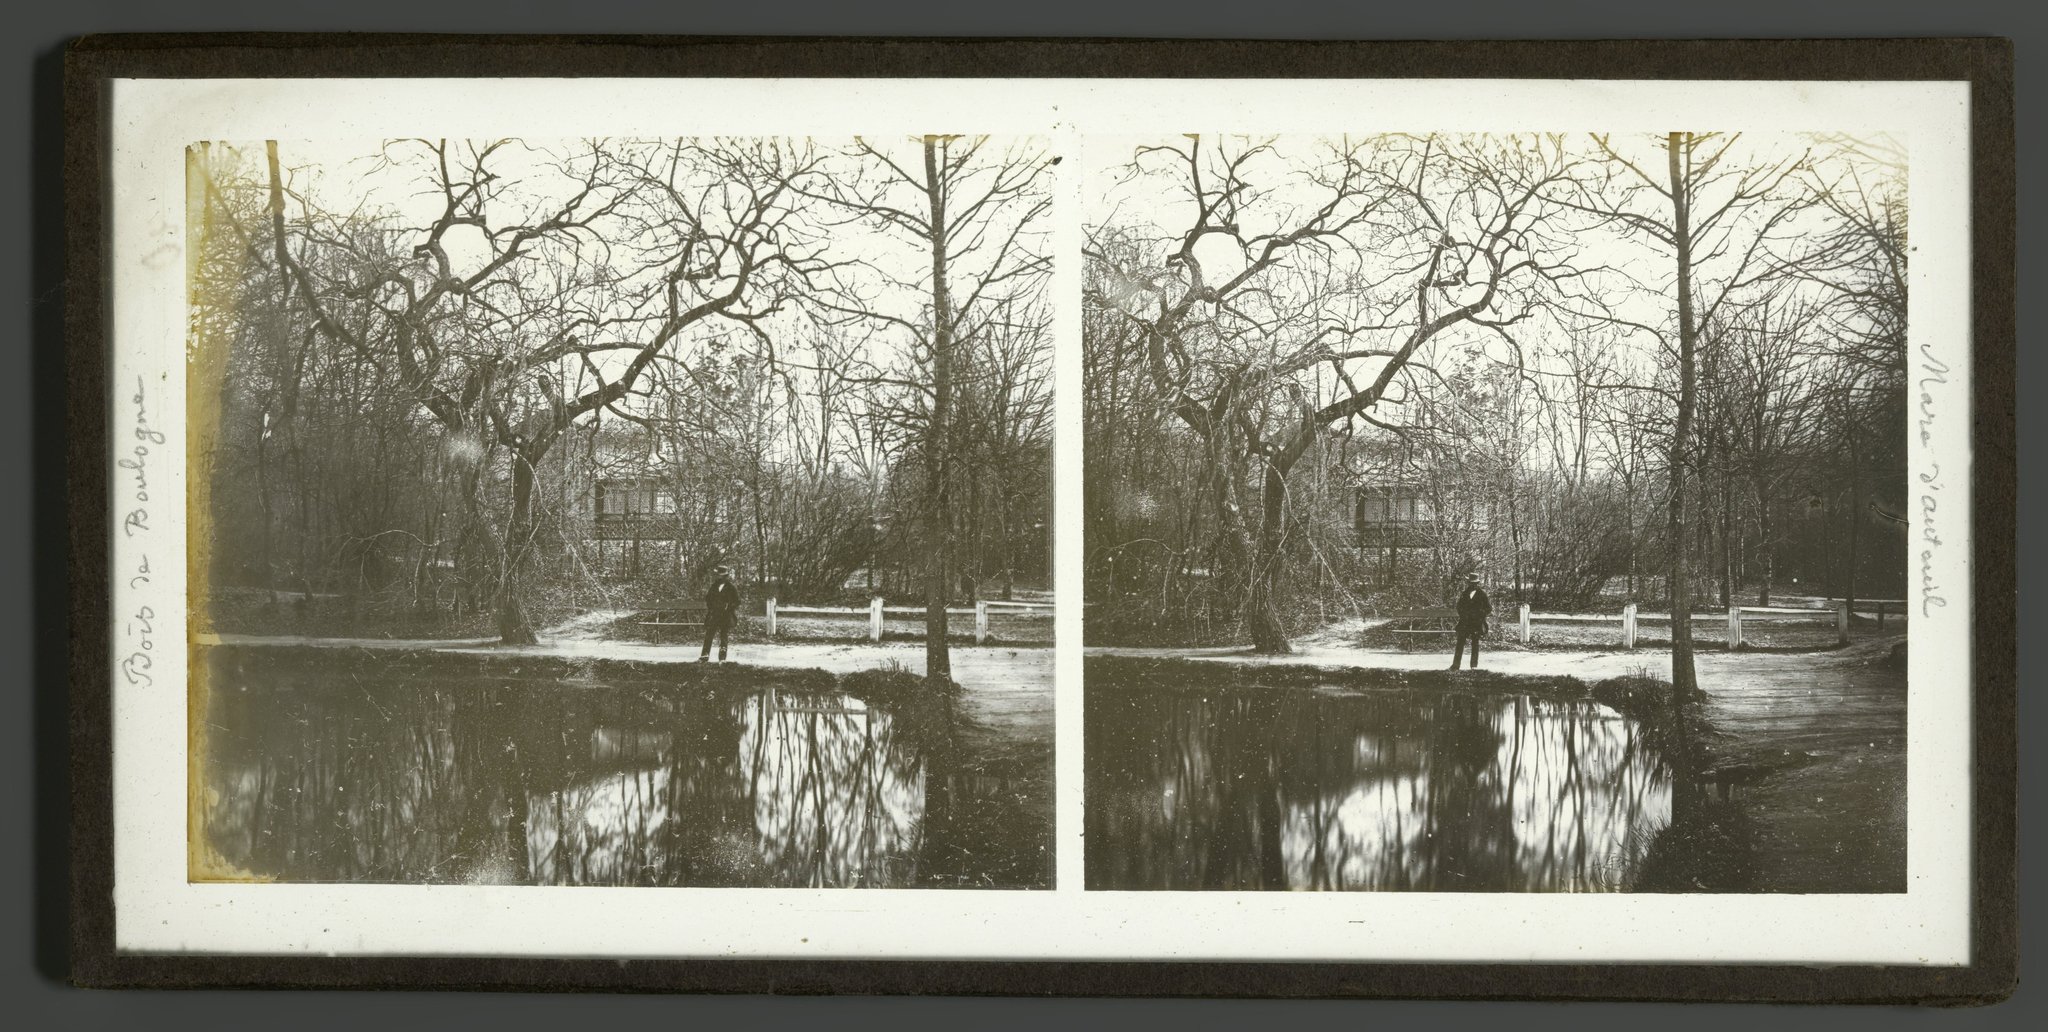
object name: stereoscopic photograph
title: Vijver van Auteuil in het Bois de Boulogne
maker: Anonymous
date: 1860-1890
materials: glass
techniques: slide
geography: bois de boulogne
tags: lake